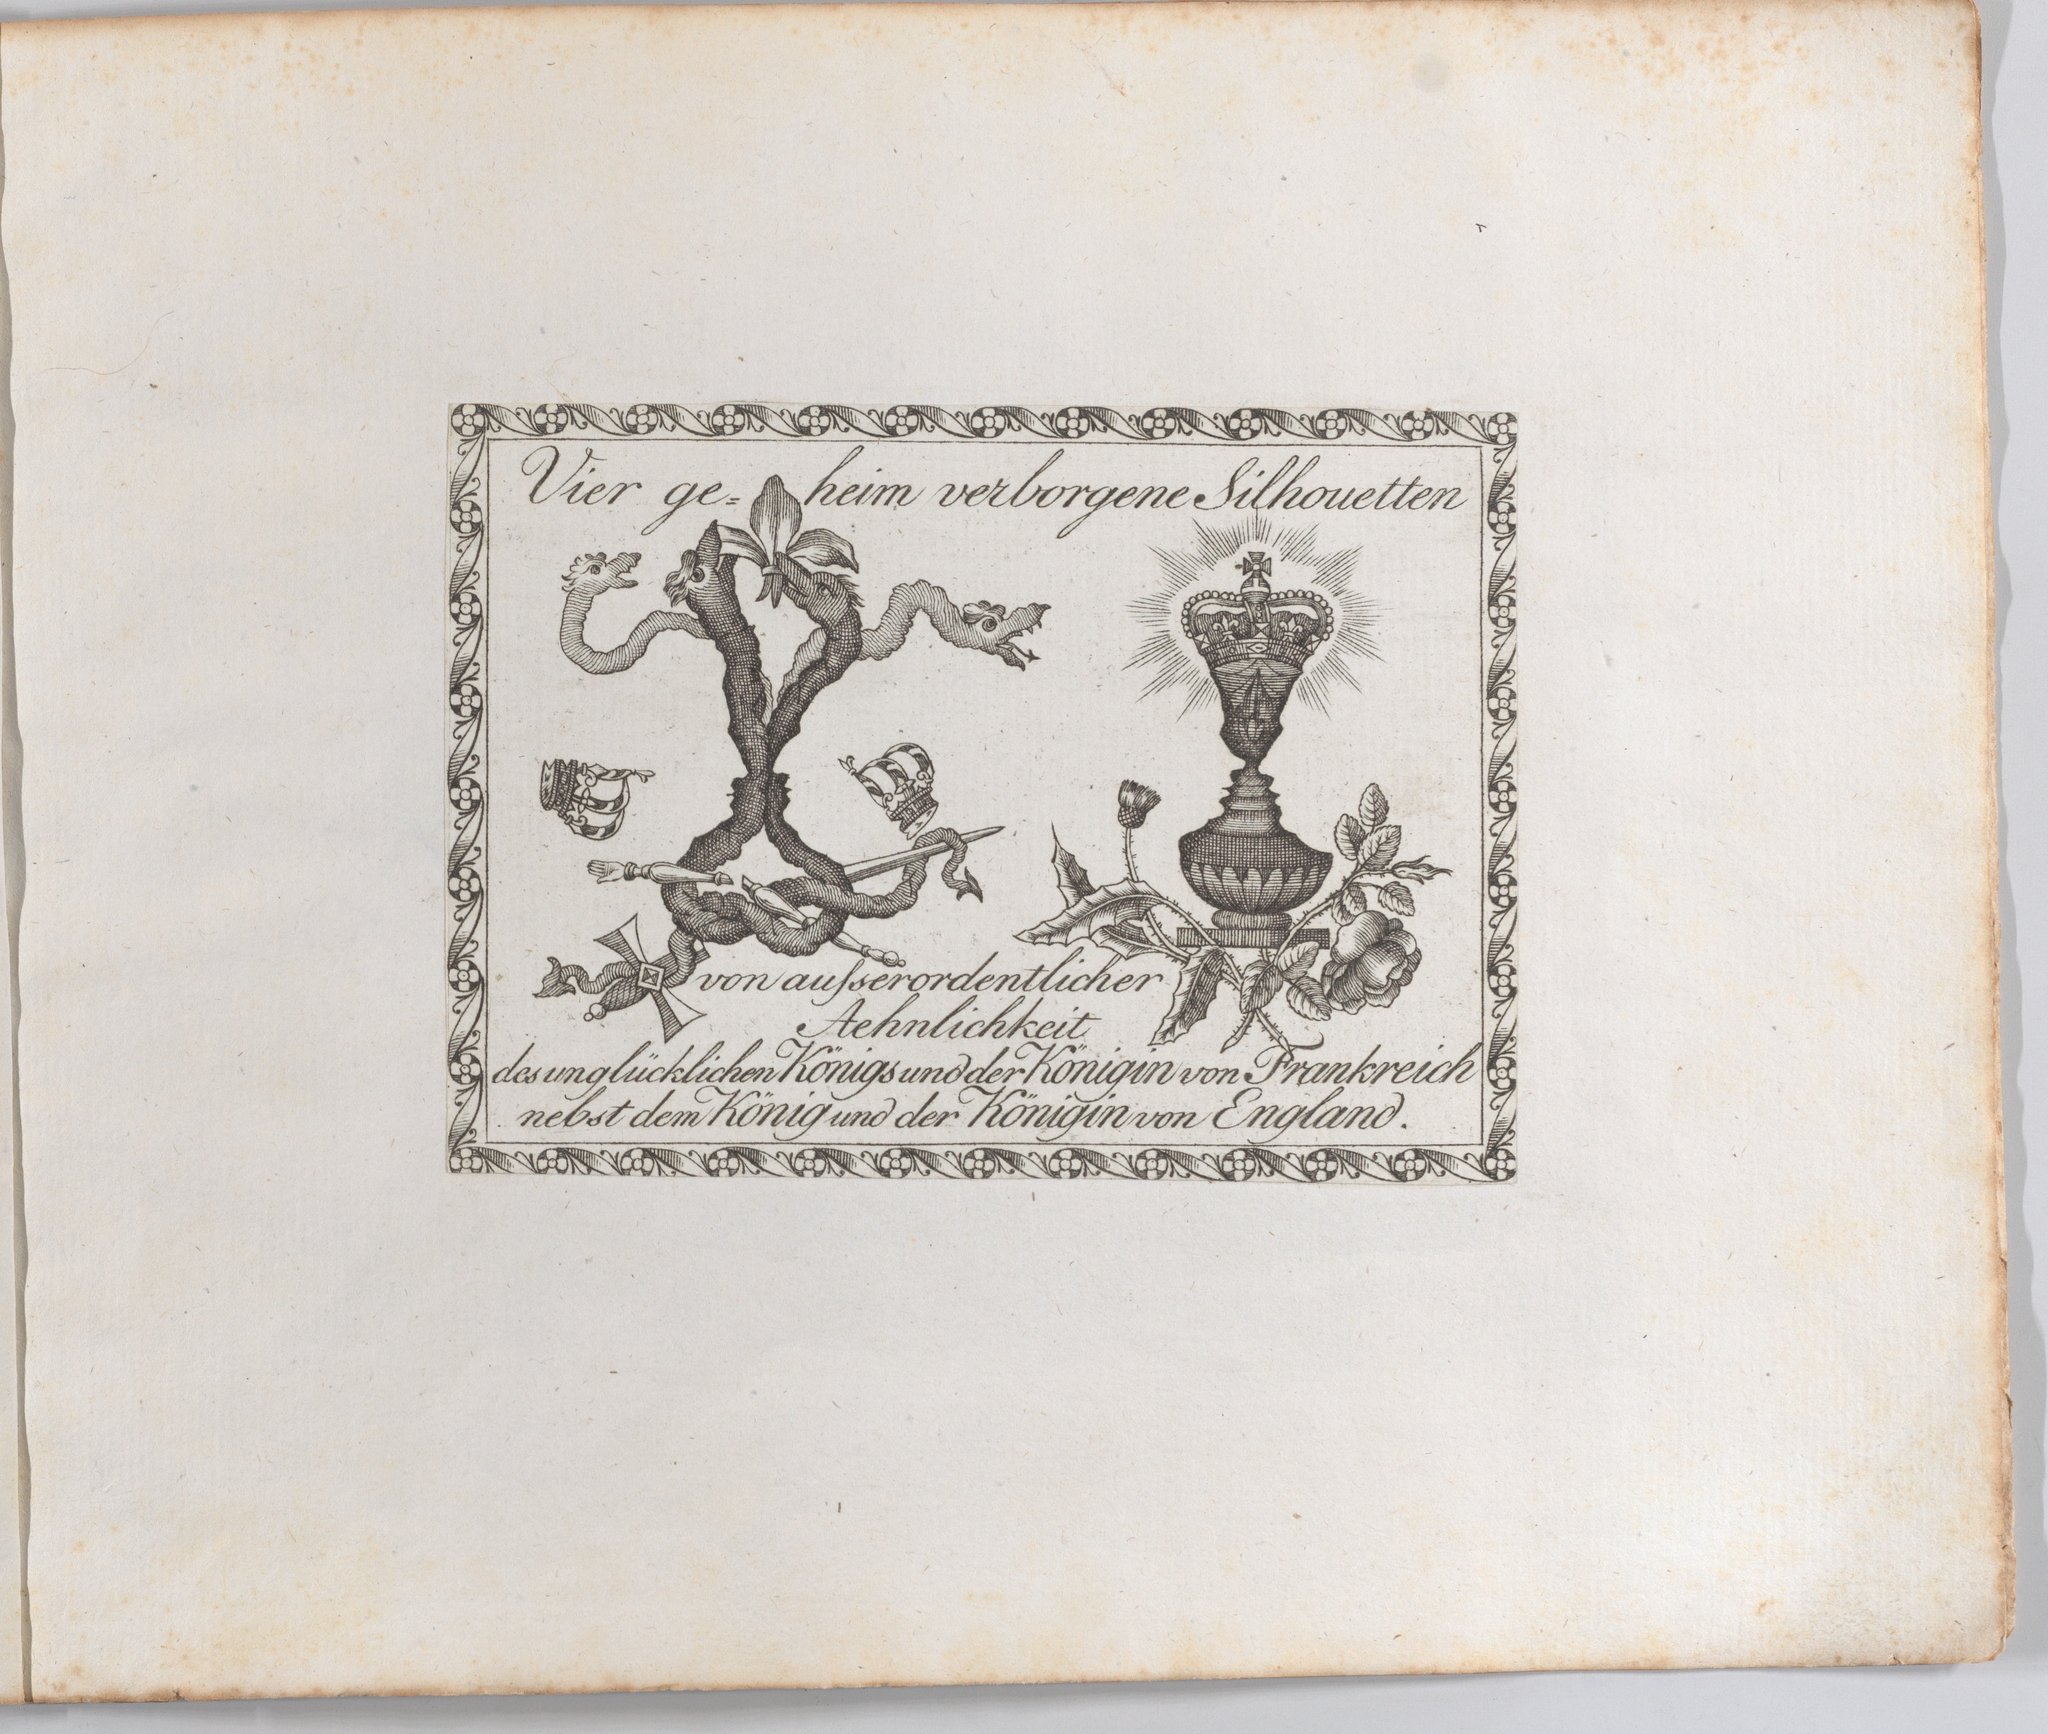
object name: album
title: Landscape containing "Four Secretly Hidden Silhouettes"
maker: anonymous, german, 18th century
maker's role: artist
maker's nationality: german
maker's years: 1700-1800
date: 1793-1800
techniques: etching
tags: kings,louis xvi,marie antoinette,queens,crowns